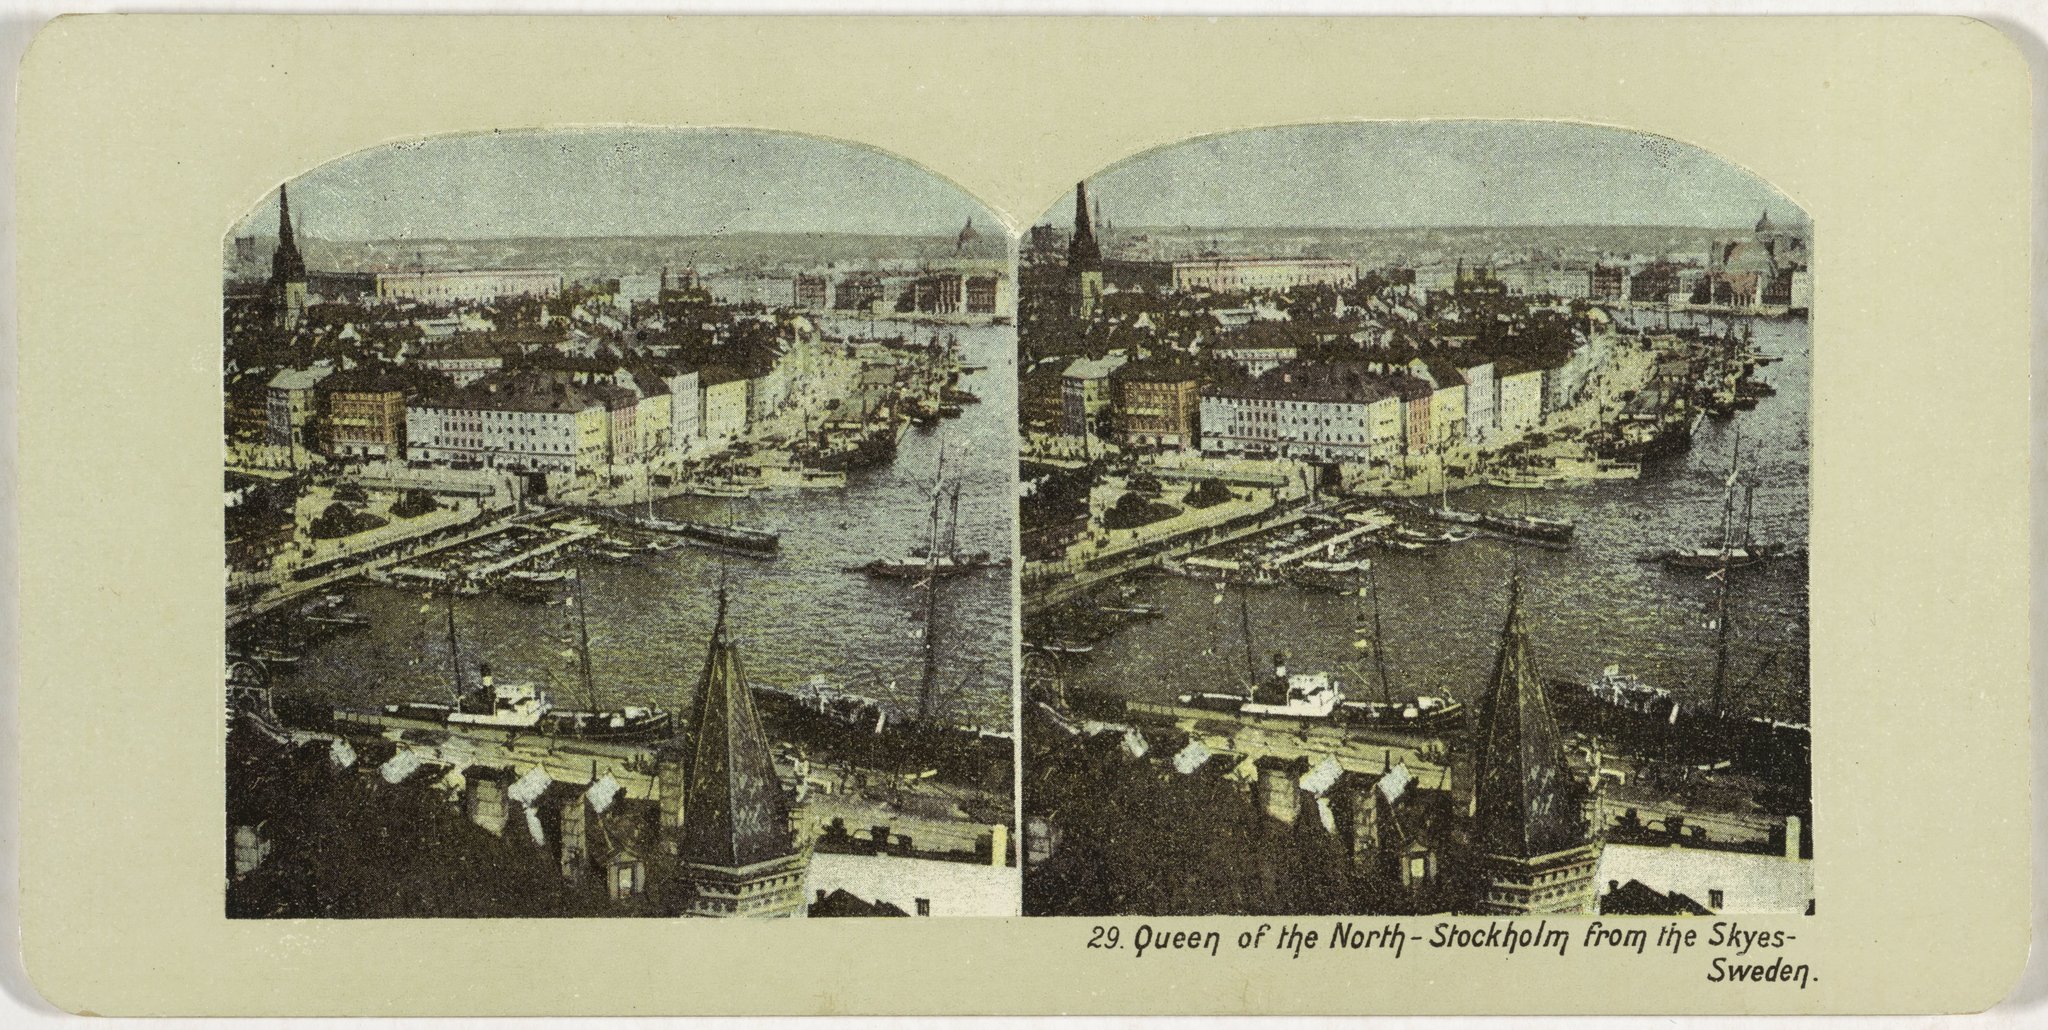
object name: photomechanical print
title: Gezicht op Stockholm van bovenaf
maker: Anonymous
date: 1898-1935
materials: paper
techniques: hand coloring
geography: stockholm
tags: city-view in general; 'veduta'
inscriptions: number: ‘29’